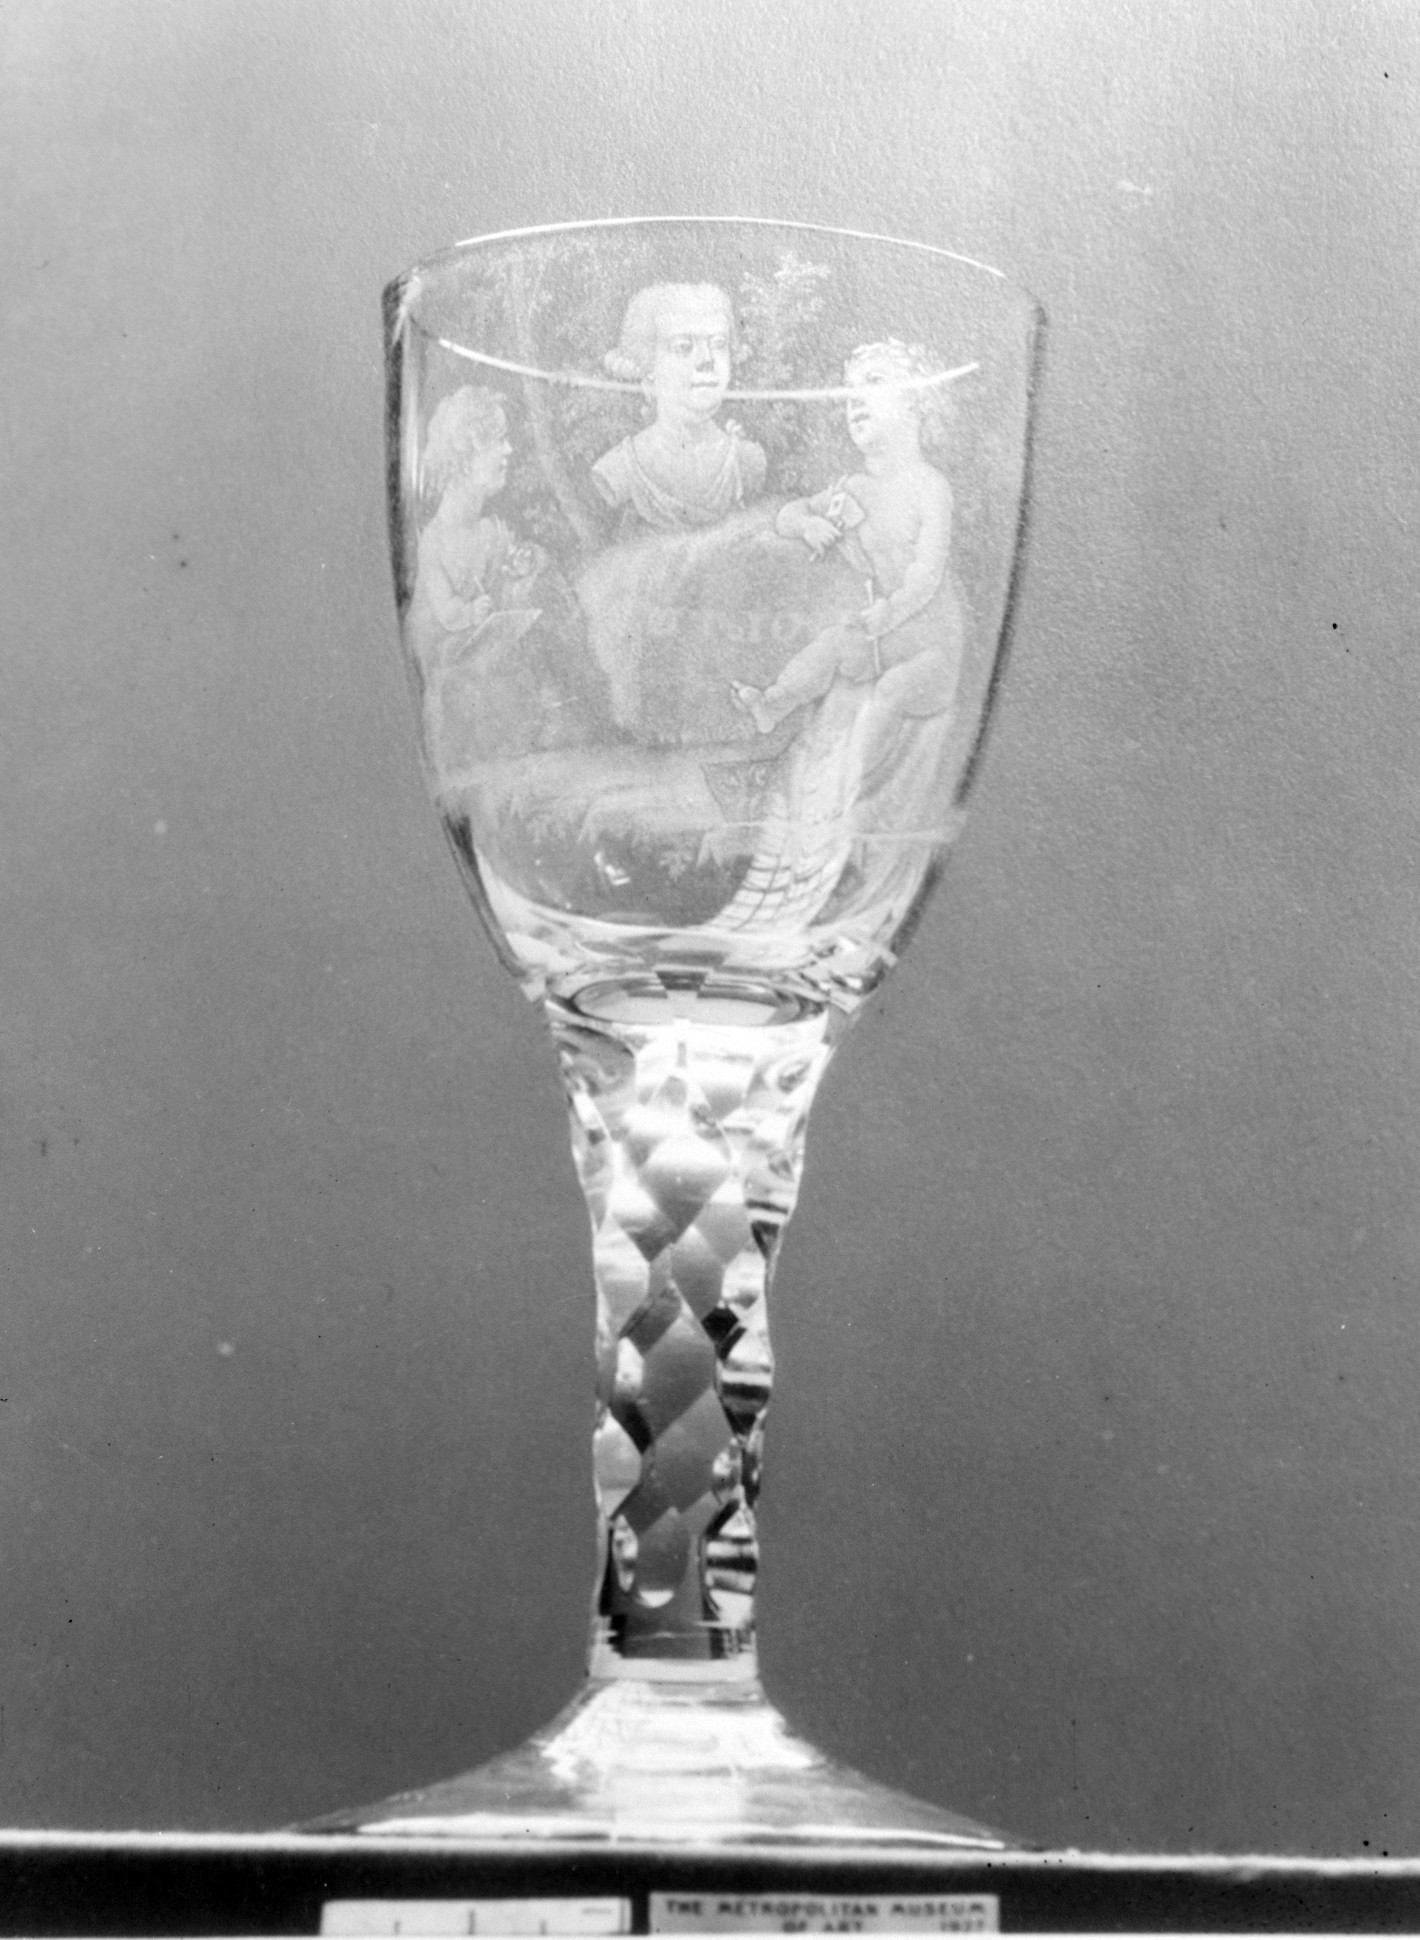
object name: wineglass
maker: david wolff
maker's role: engraver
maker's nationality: dutch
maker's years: 1732-1798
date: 1794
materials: glass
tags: men,portraits,putti